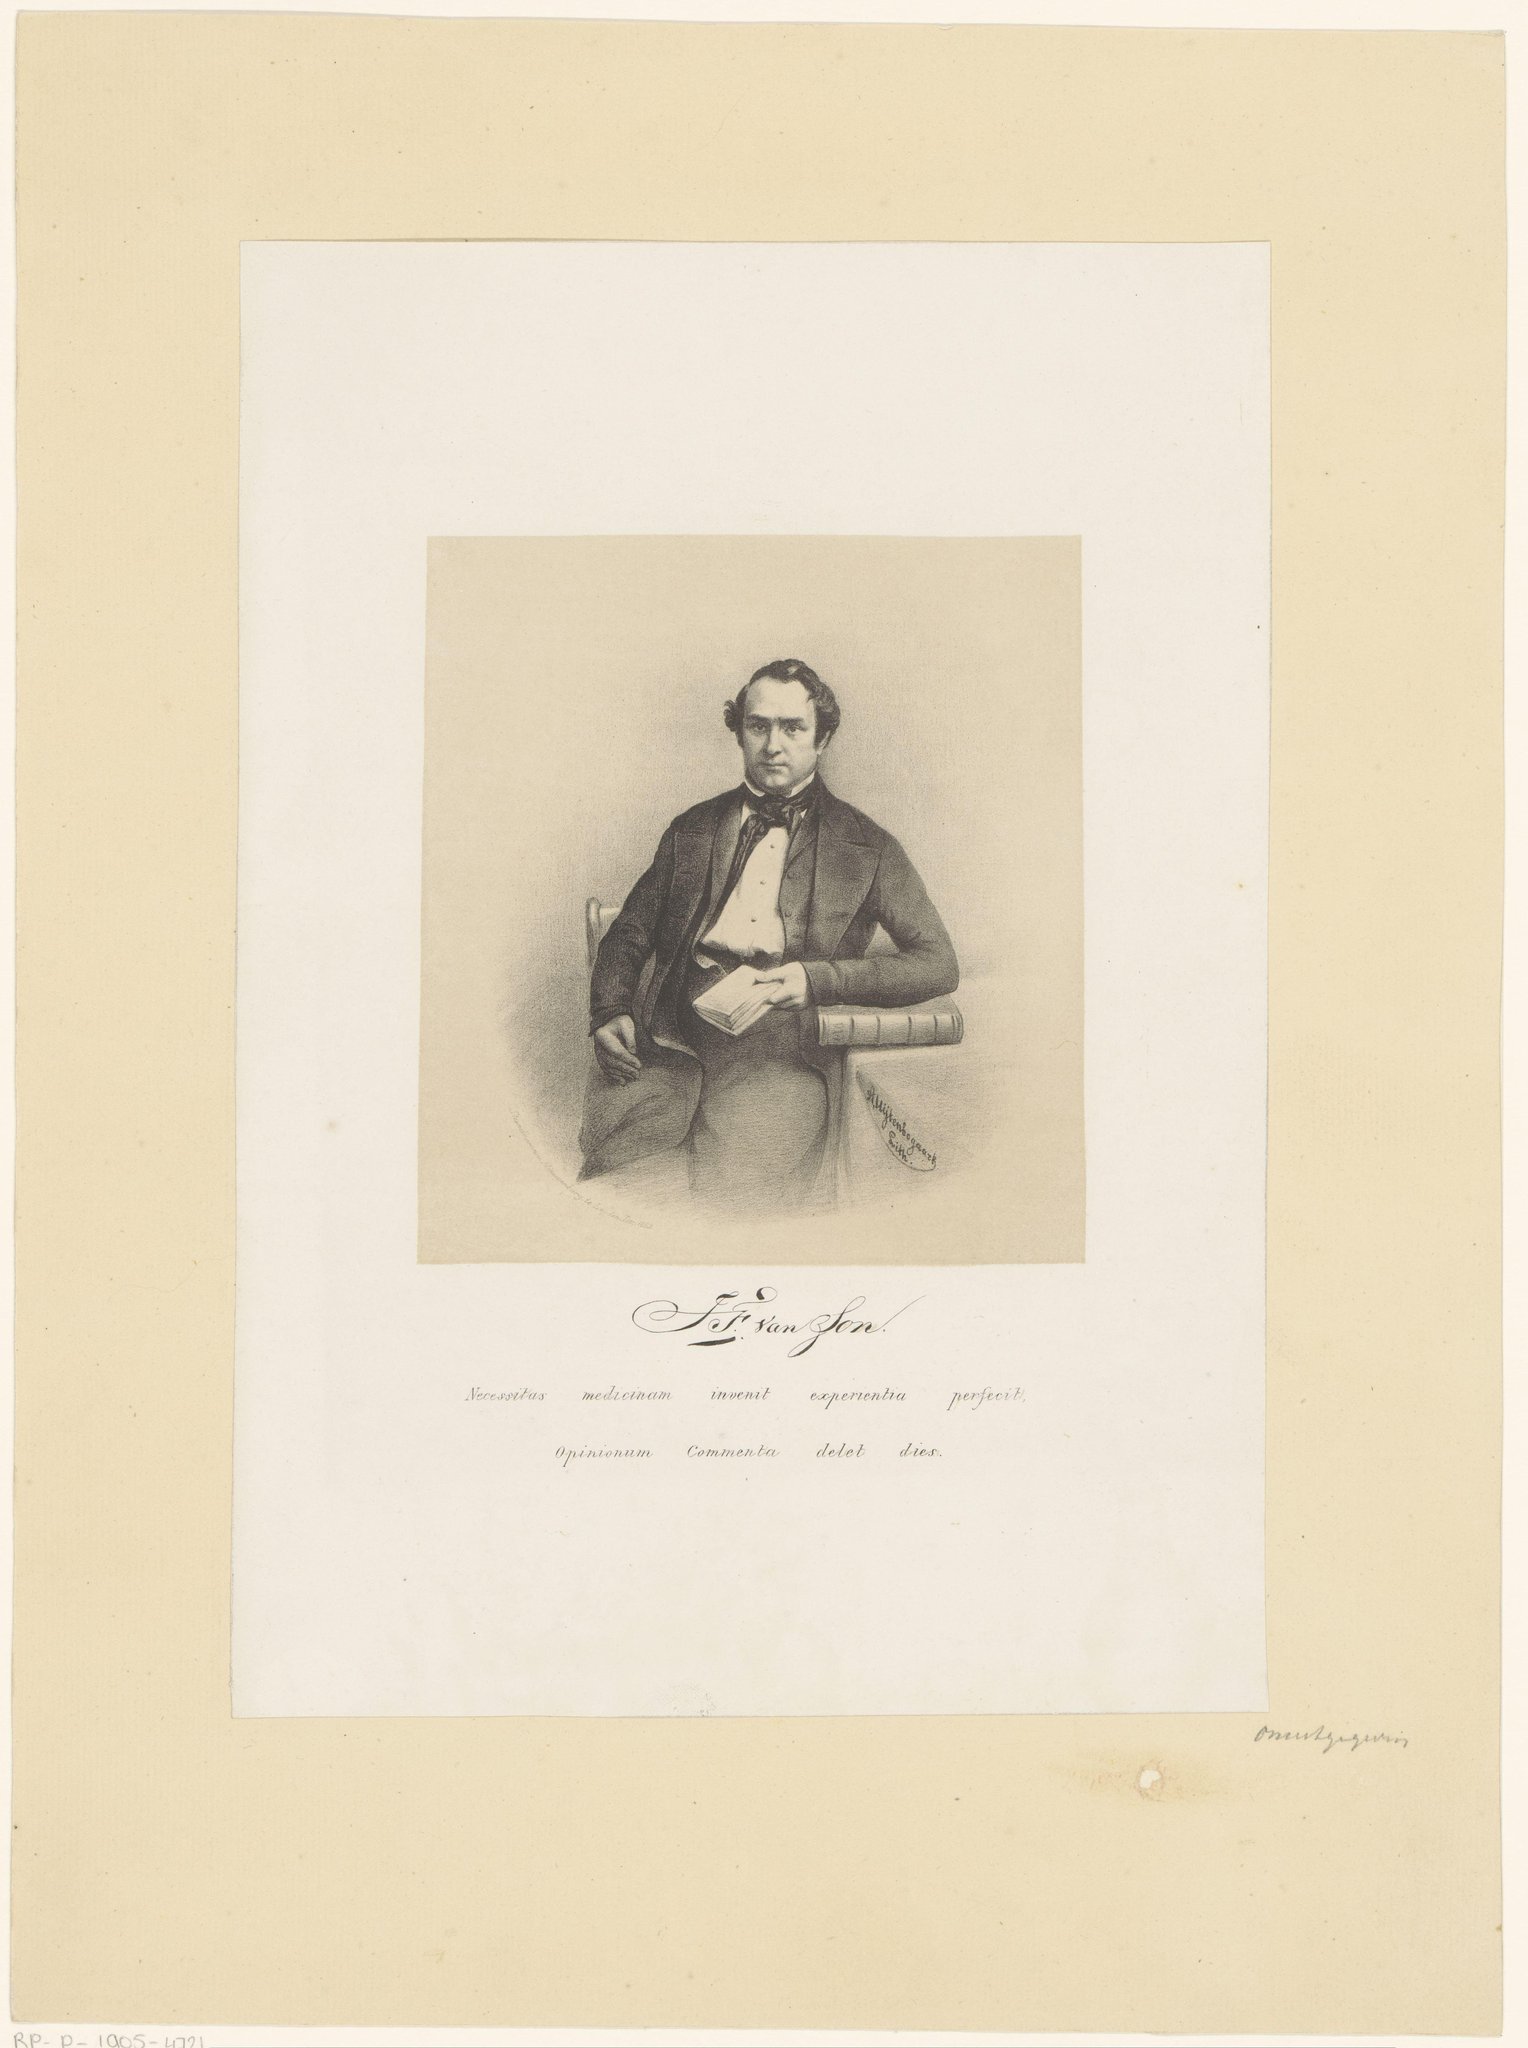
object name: print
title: J.F. van Son / Necessitas medicinam invenit experientia perfecit, Opinionum Commenta delet dies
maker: abraham uytenbogaart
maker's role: print maker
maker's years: 1803-1865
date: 1852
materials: paper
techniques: tone lithography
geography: leiden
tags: historical persons, physician, doctor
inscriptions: collector's mark: Lugt 2228